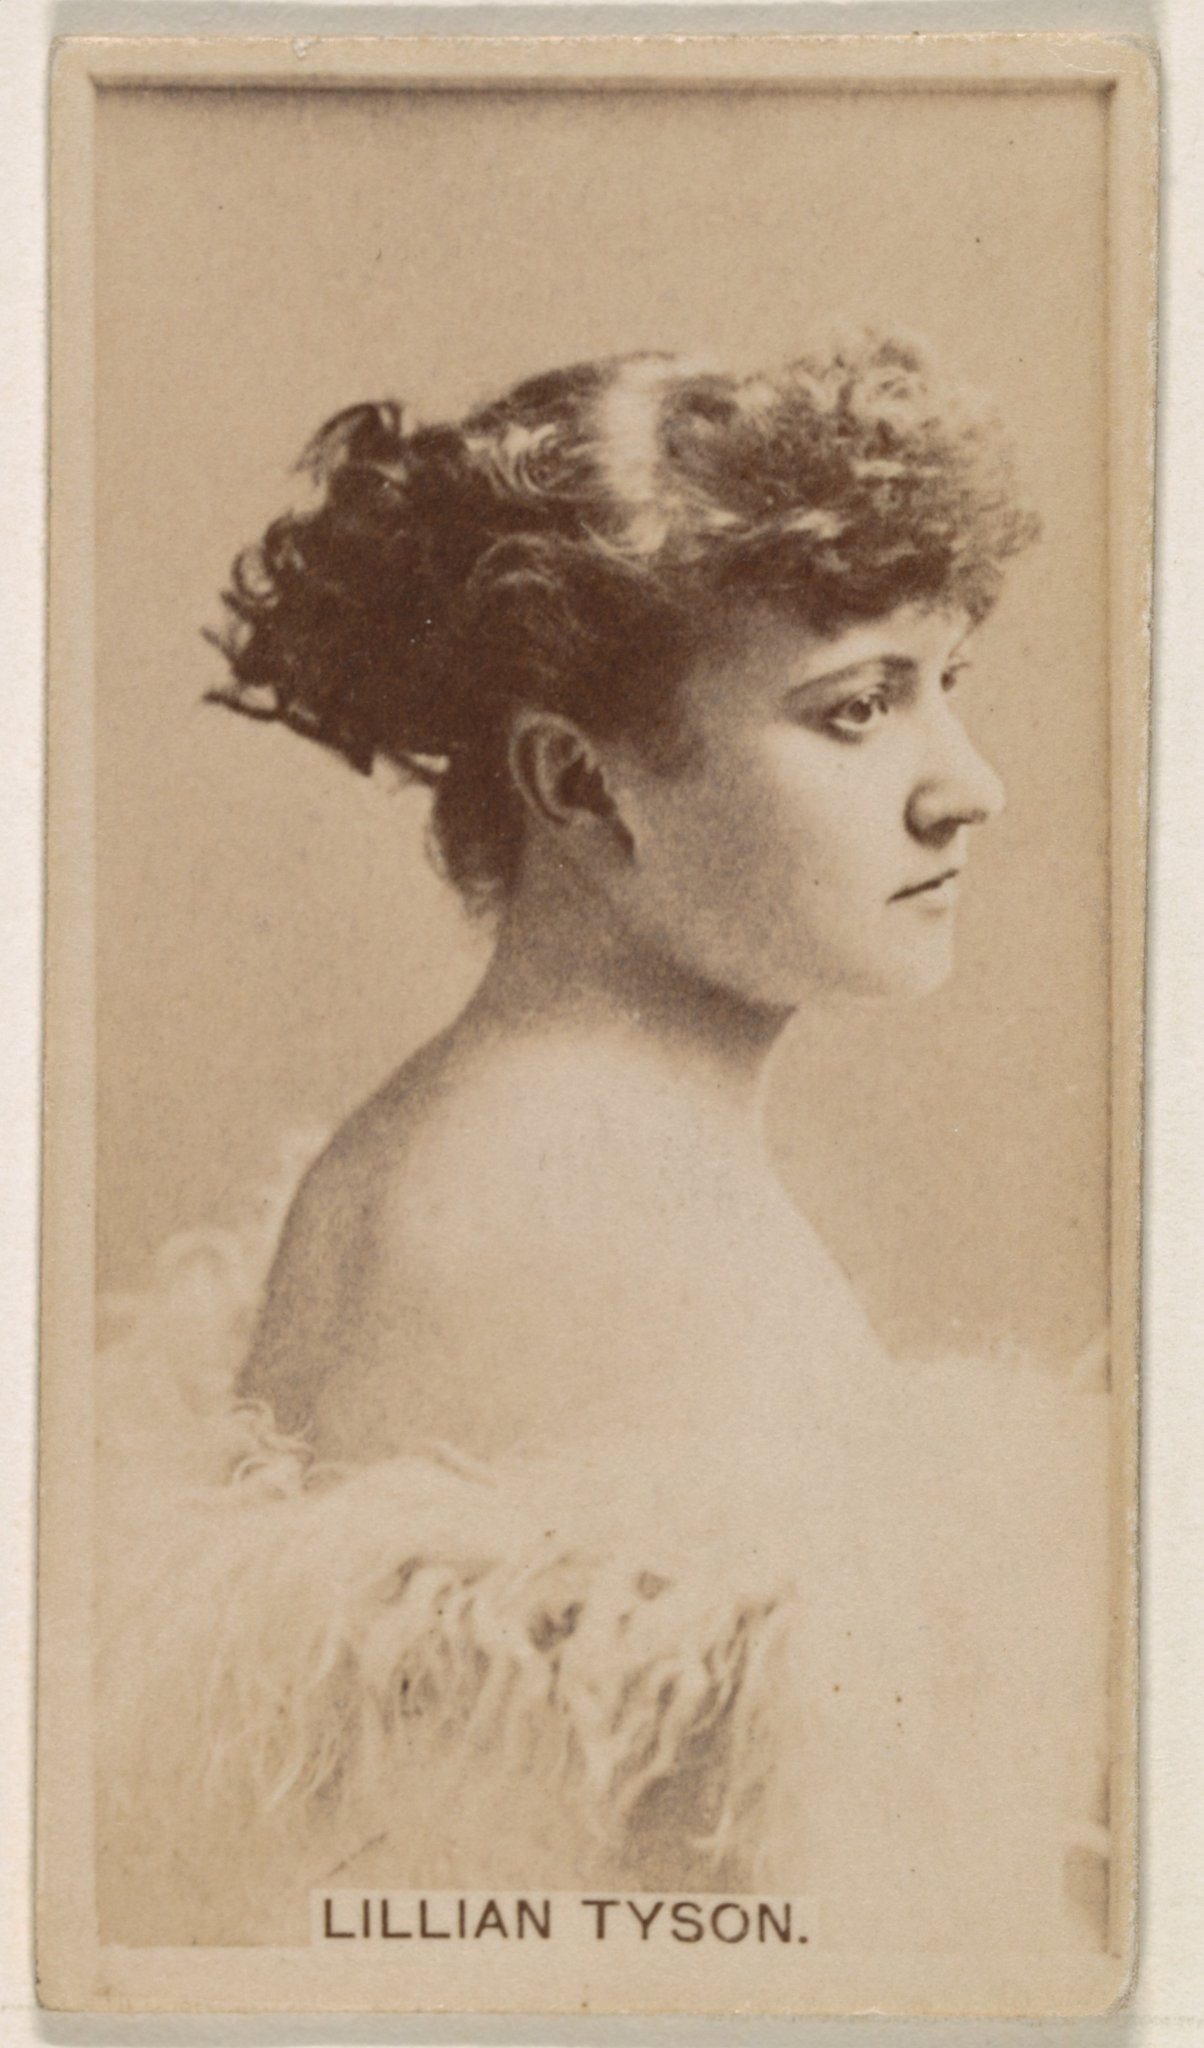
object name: photograph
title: Lillian Tyson, from the Actresses series (N245) issued by Kinney Brothers to promote Sweet Caporal Cigarettes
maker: kinney brothers tobacco company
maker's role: publisher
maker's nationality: american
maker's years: 1869-2011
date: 1890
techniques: albumen silver print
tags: women,actresses